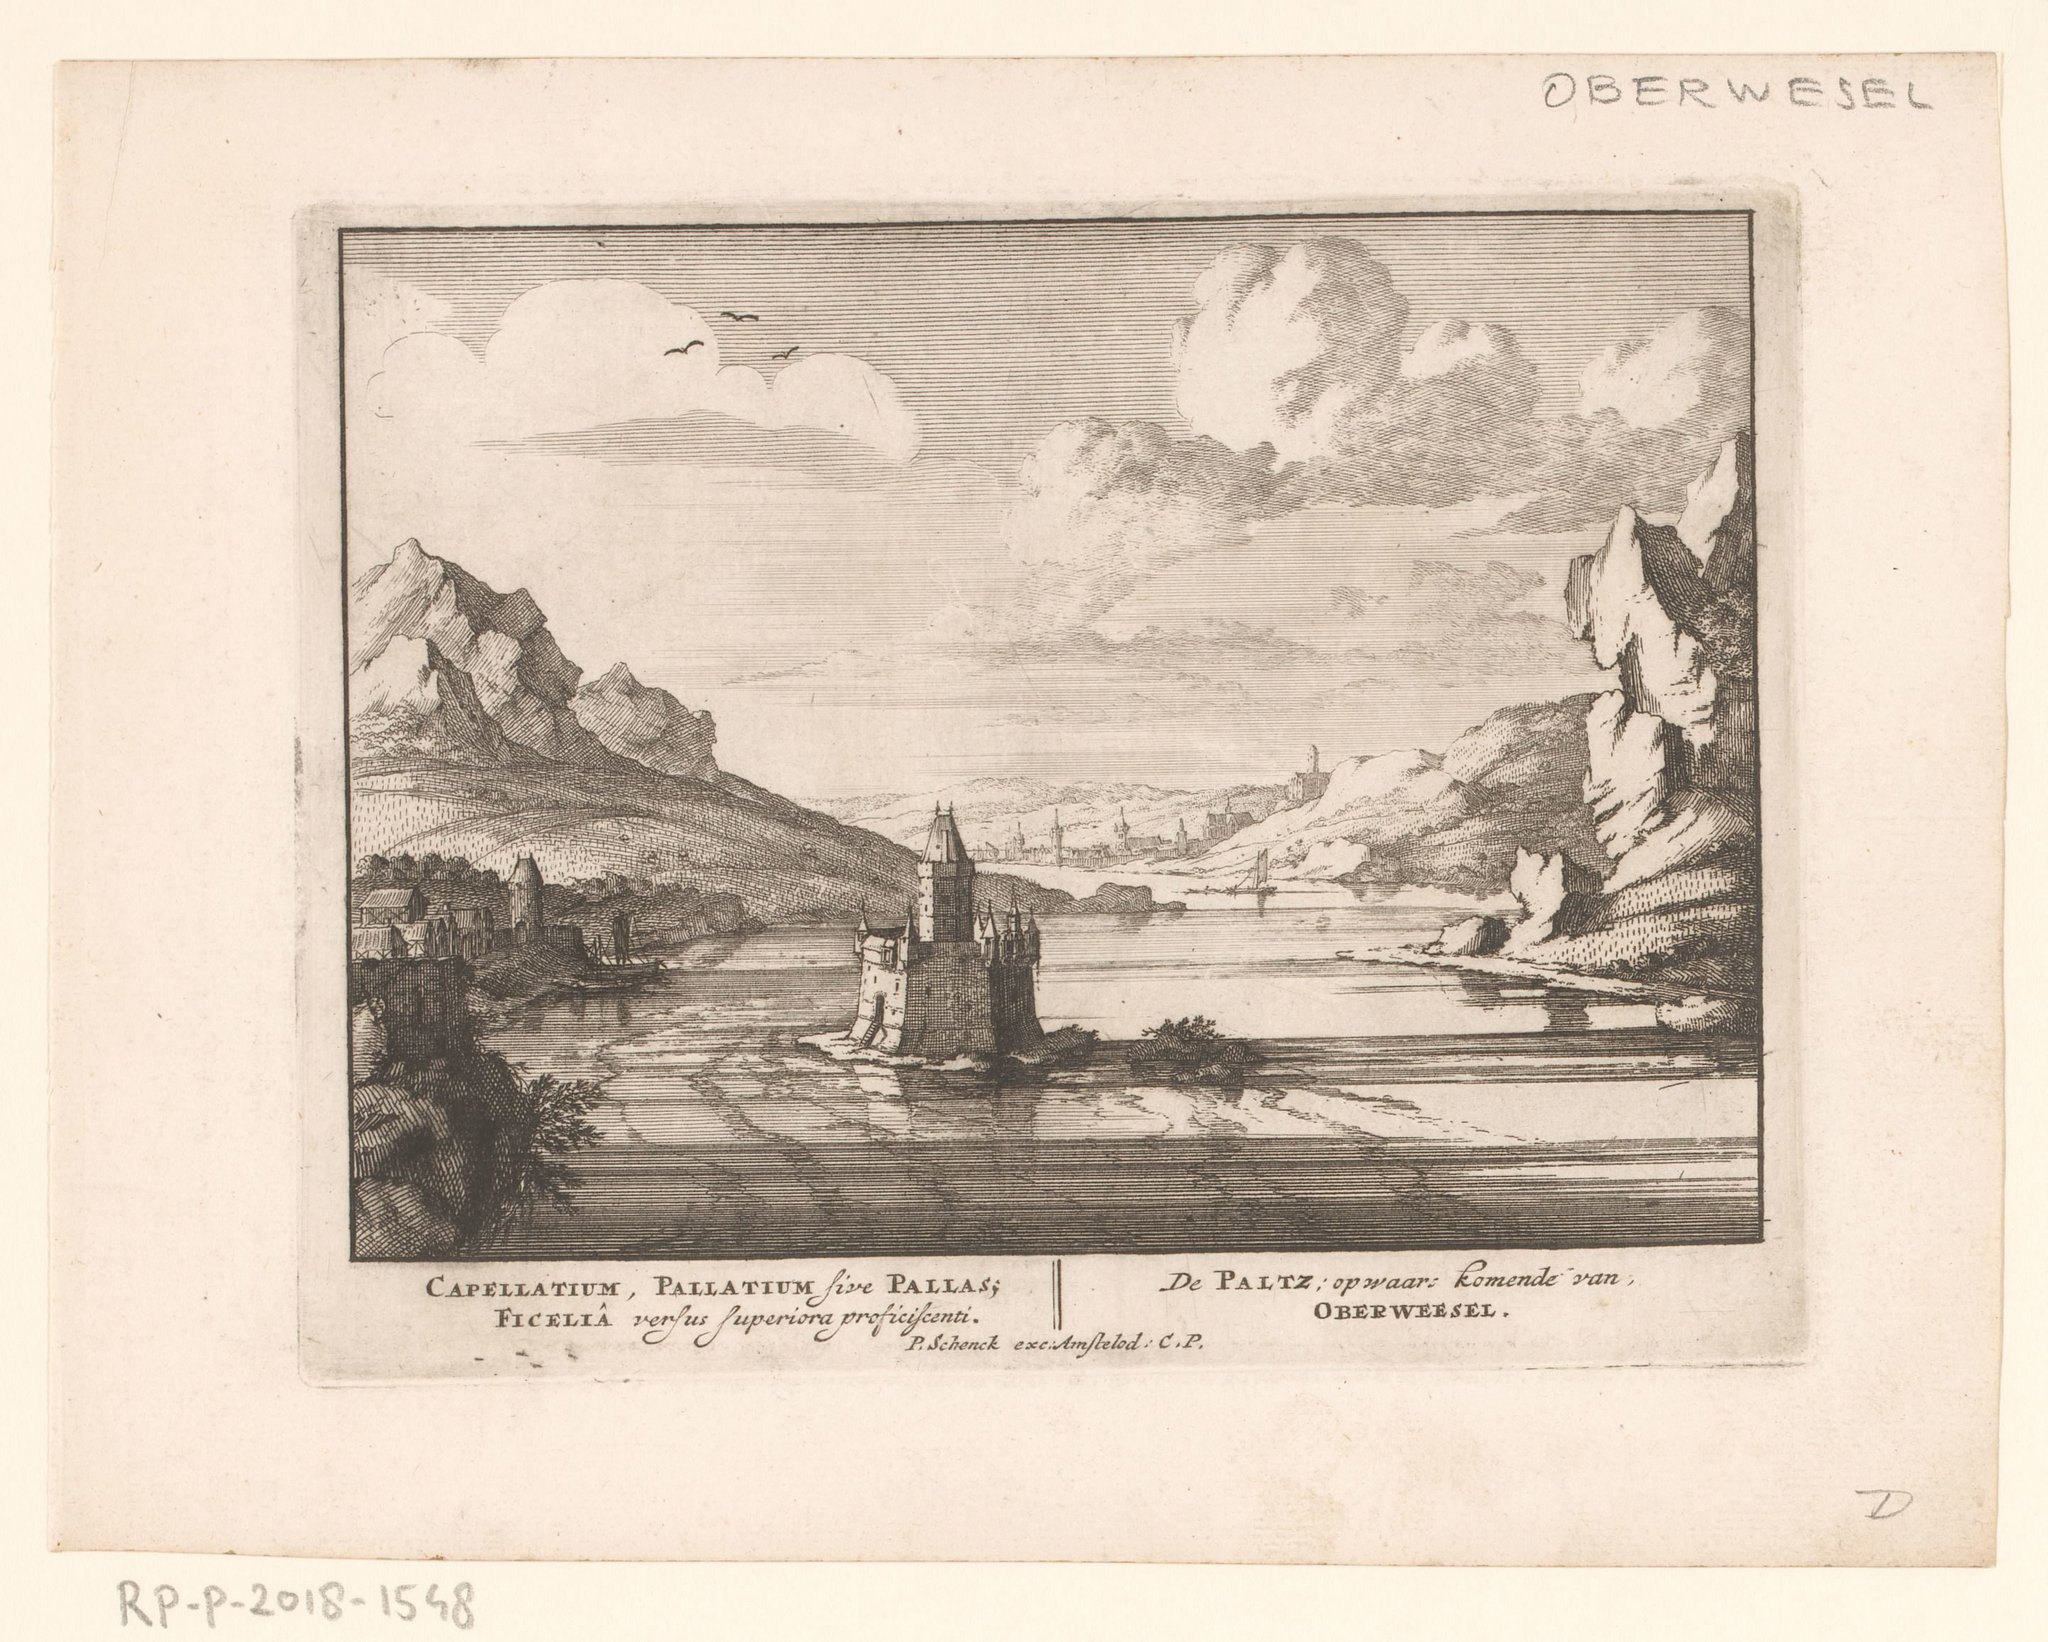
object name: print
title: De Paltz; opwaar: komende van Oberwesel / Capellatium, Pallatium sive Pallas; Ficelia versus superiora proficiscenti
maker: pieter schenk (i)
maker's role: print maker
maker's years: 1660-1711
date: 1694-1697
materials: paper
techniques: engraving, etching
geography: amsterdam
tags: castle, prospect of city, town panorama, silhouette of city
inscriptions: collector's mark: Lugt 2228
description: Prent ook gebruikt in: Admirandorum quadruplex spectaculum / delectum, pictum, et aeri in cisum, per Johannem van Call. Amsterdam: Pieter Schenk (I), ca. 1694-1697.